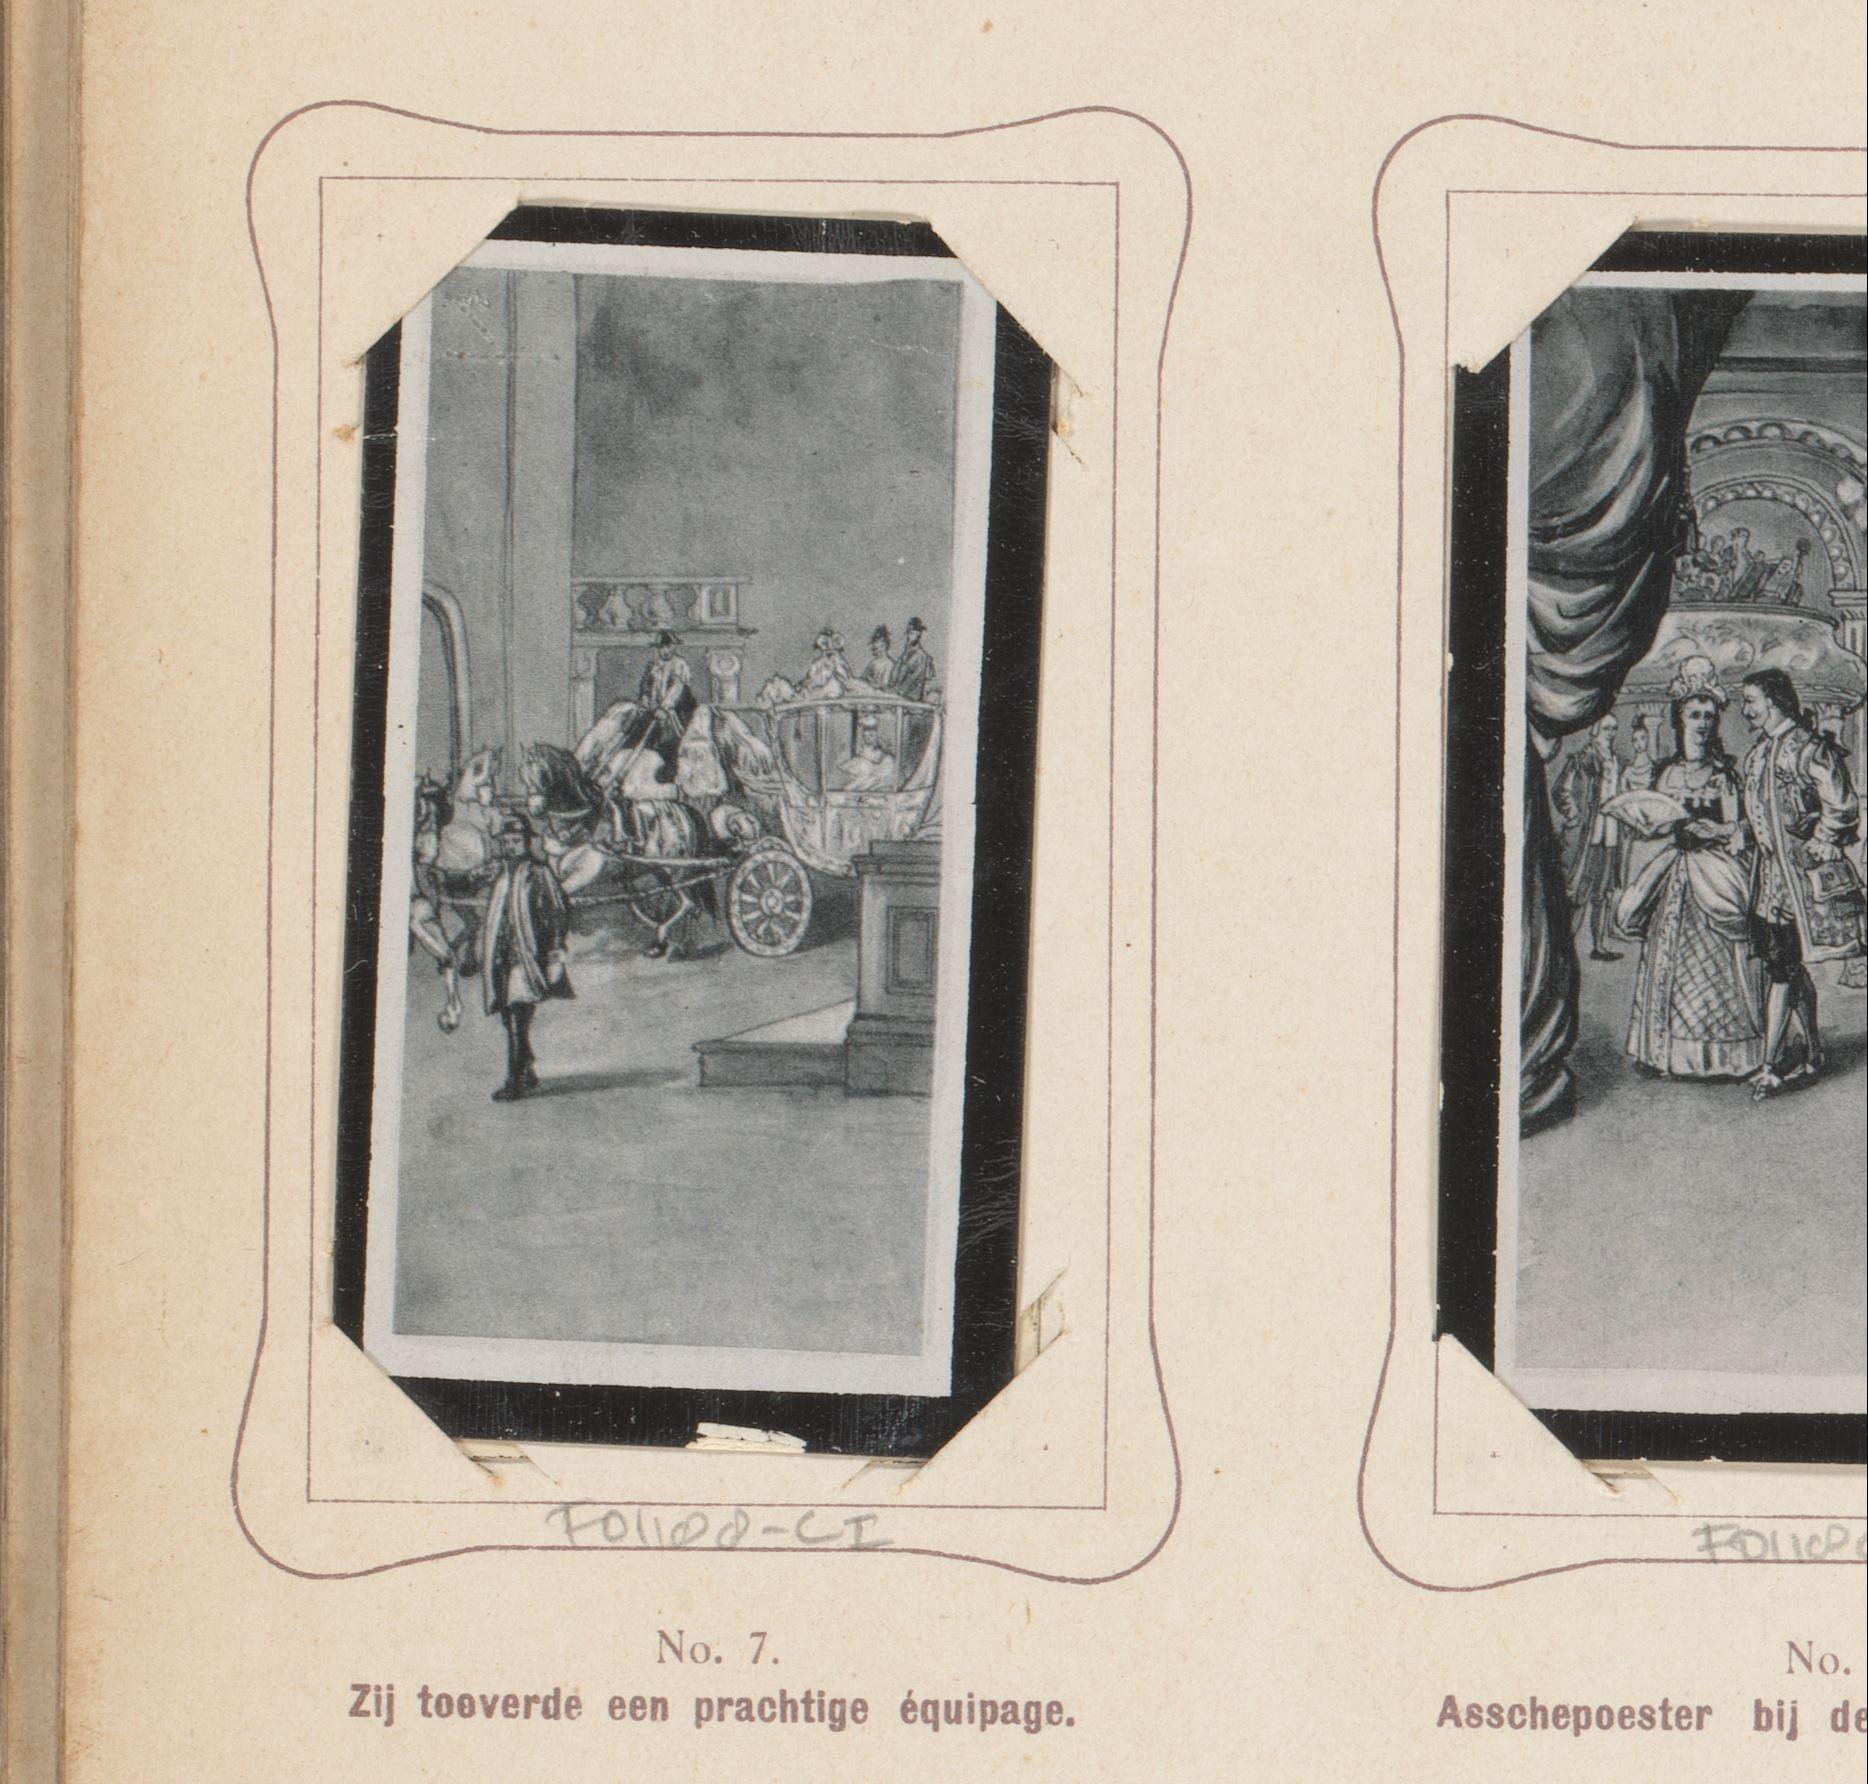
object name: reproduction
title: Reproductie van een tekening van de heks die een koets tovert voor Assepoester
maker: Anonymous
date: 1906-1907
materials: paper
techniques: photograph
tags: tales and fairy tales (with title)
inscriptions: inscription: ‘No. 7./ Zij tooverde een prachtige équipage.’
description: Deze prent maakt deel uit van een album.